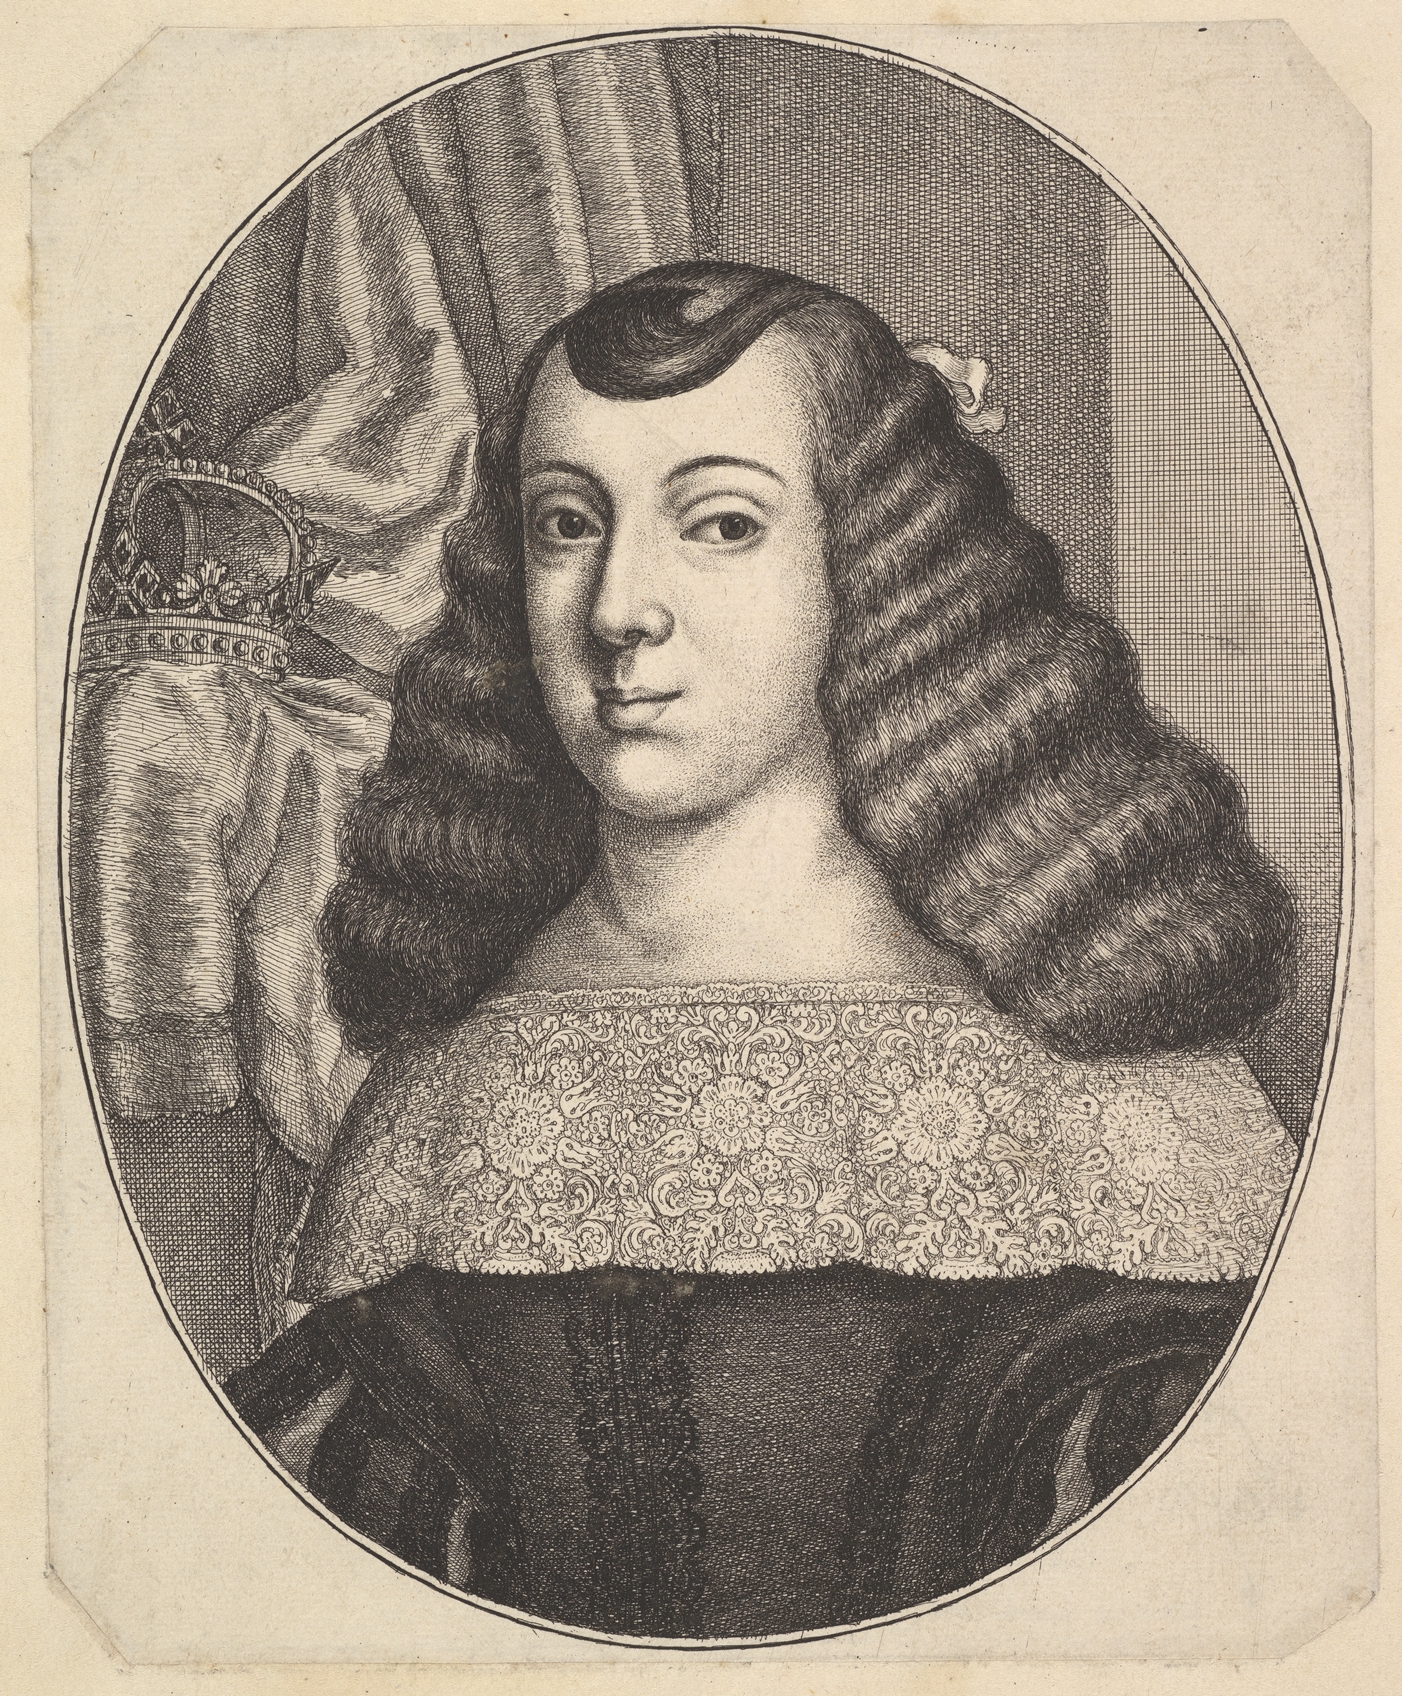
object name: print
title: Catherine of Braganza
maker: wenceslaus hollar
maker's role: artist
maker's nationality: bohemian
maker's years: 1607-1677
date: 1661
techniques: etching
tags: portraits,women